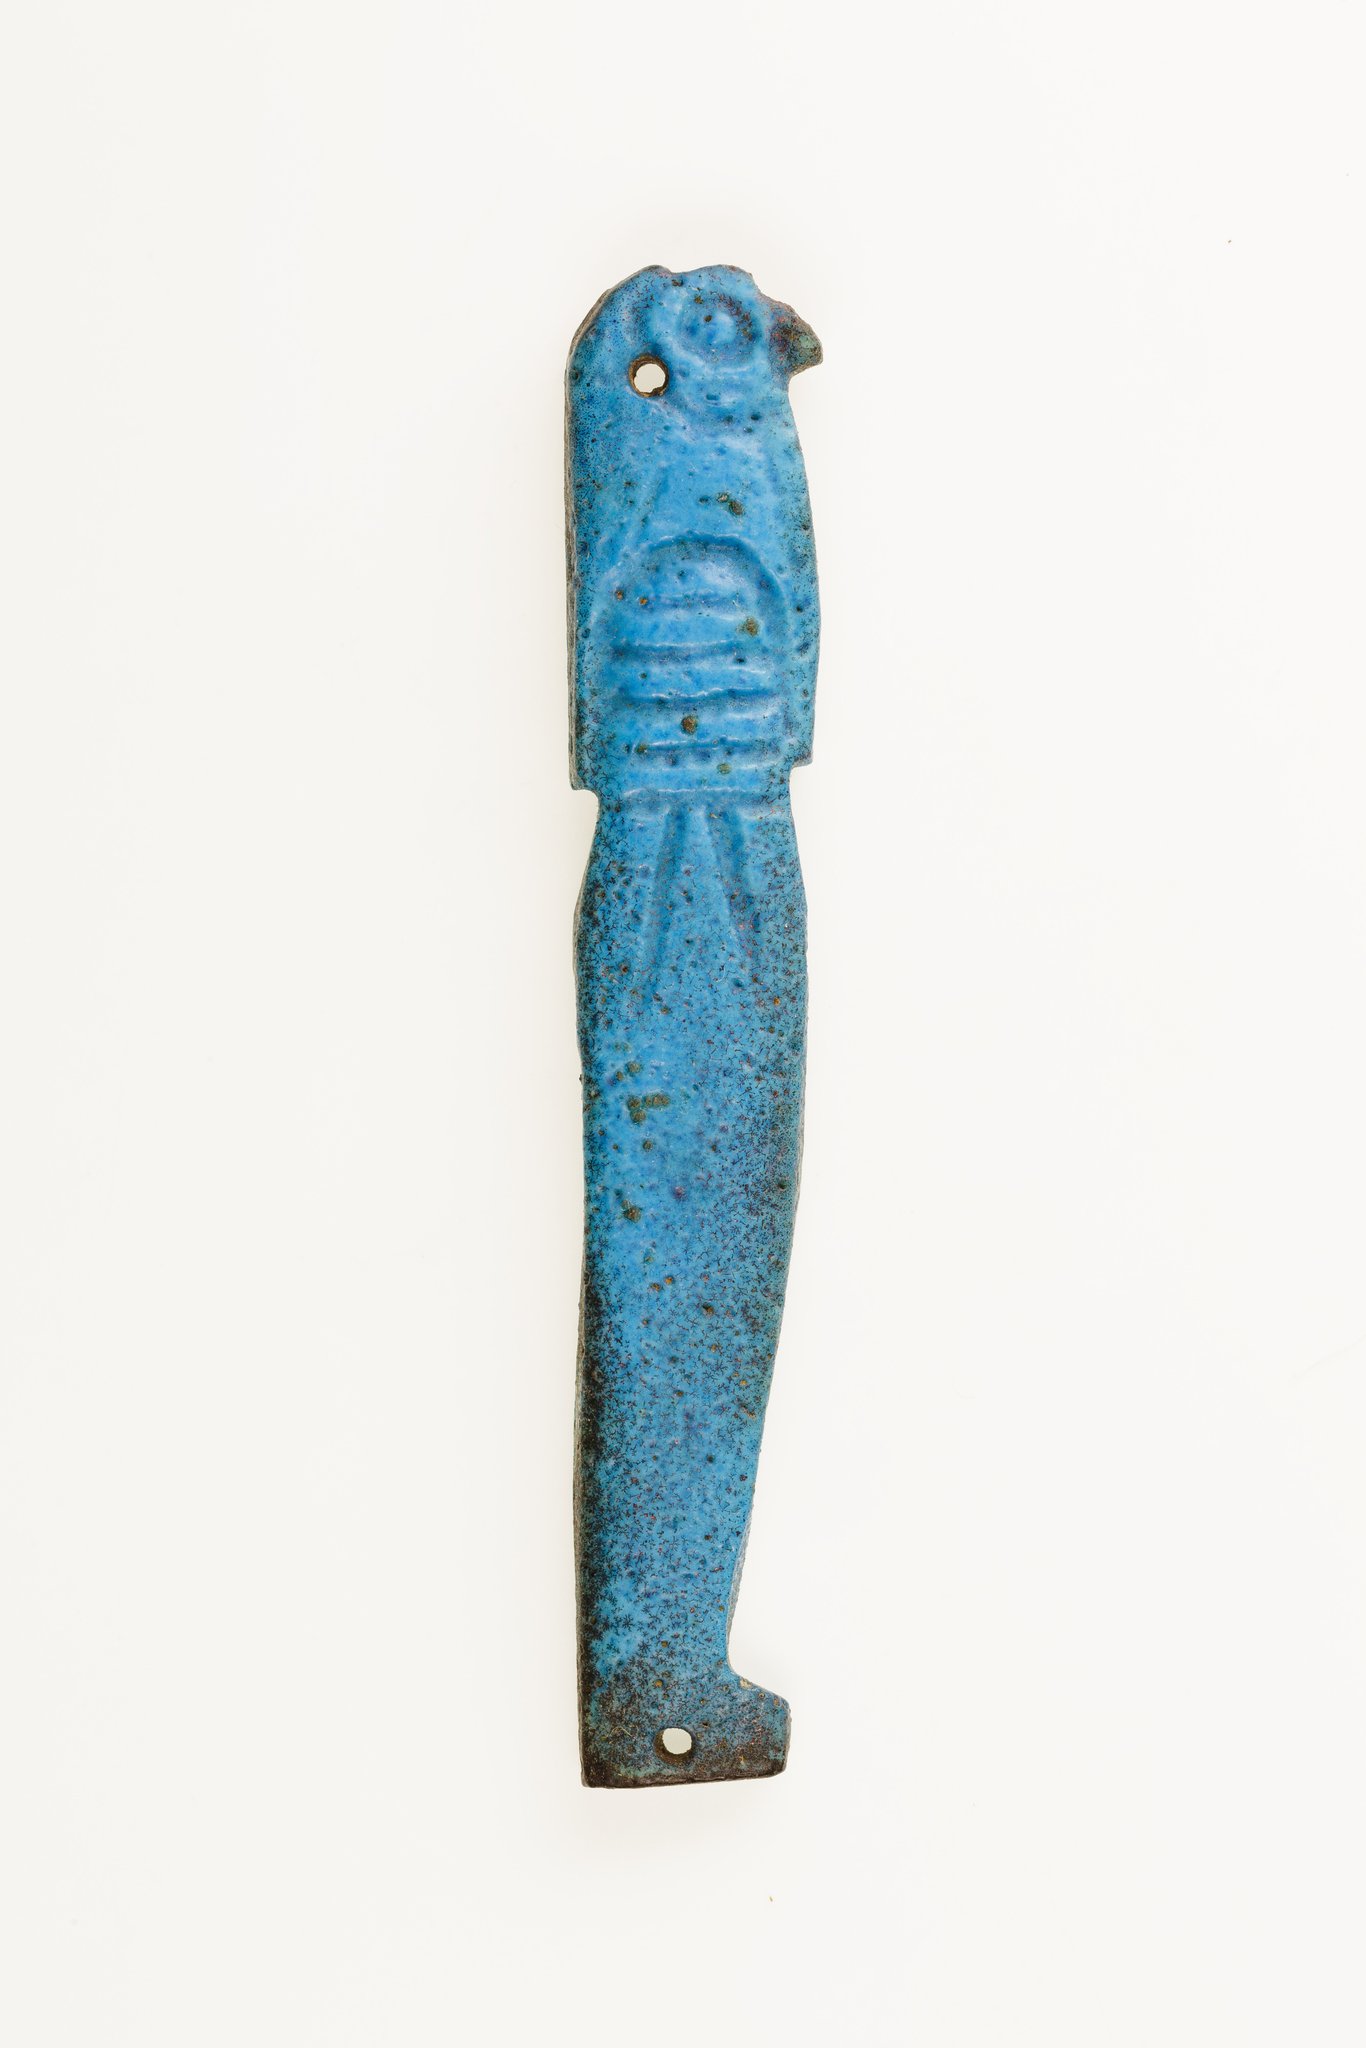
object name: amulet, son of horus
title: Son of Horus (Qebehsenuf) from Bead Net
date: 1070-525 BCE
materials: faience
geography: egypt